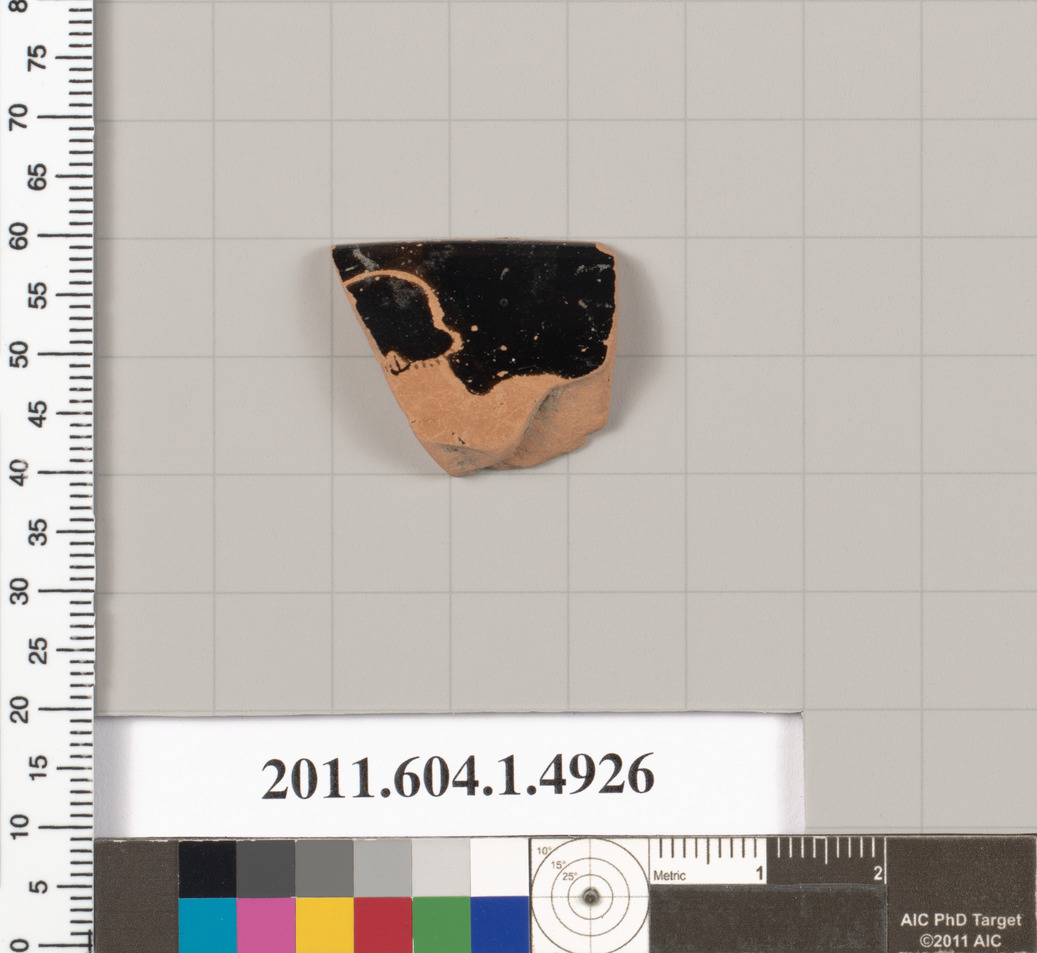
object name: kylix fragment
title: Terracotta rim fragment of a kylix (drinking cup)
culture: greek, attic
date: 480-470 BCE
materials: terracotta